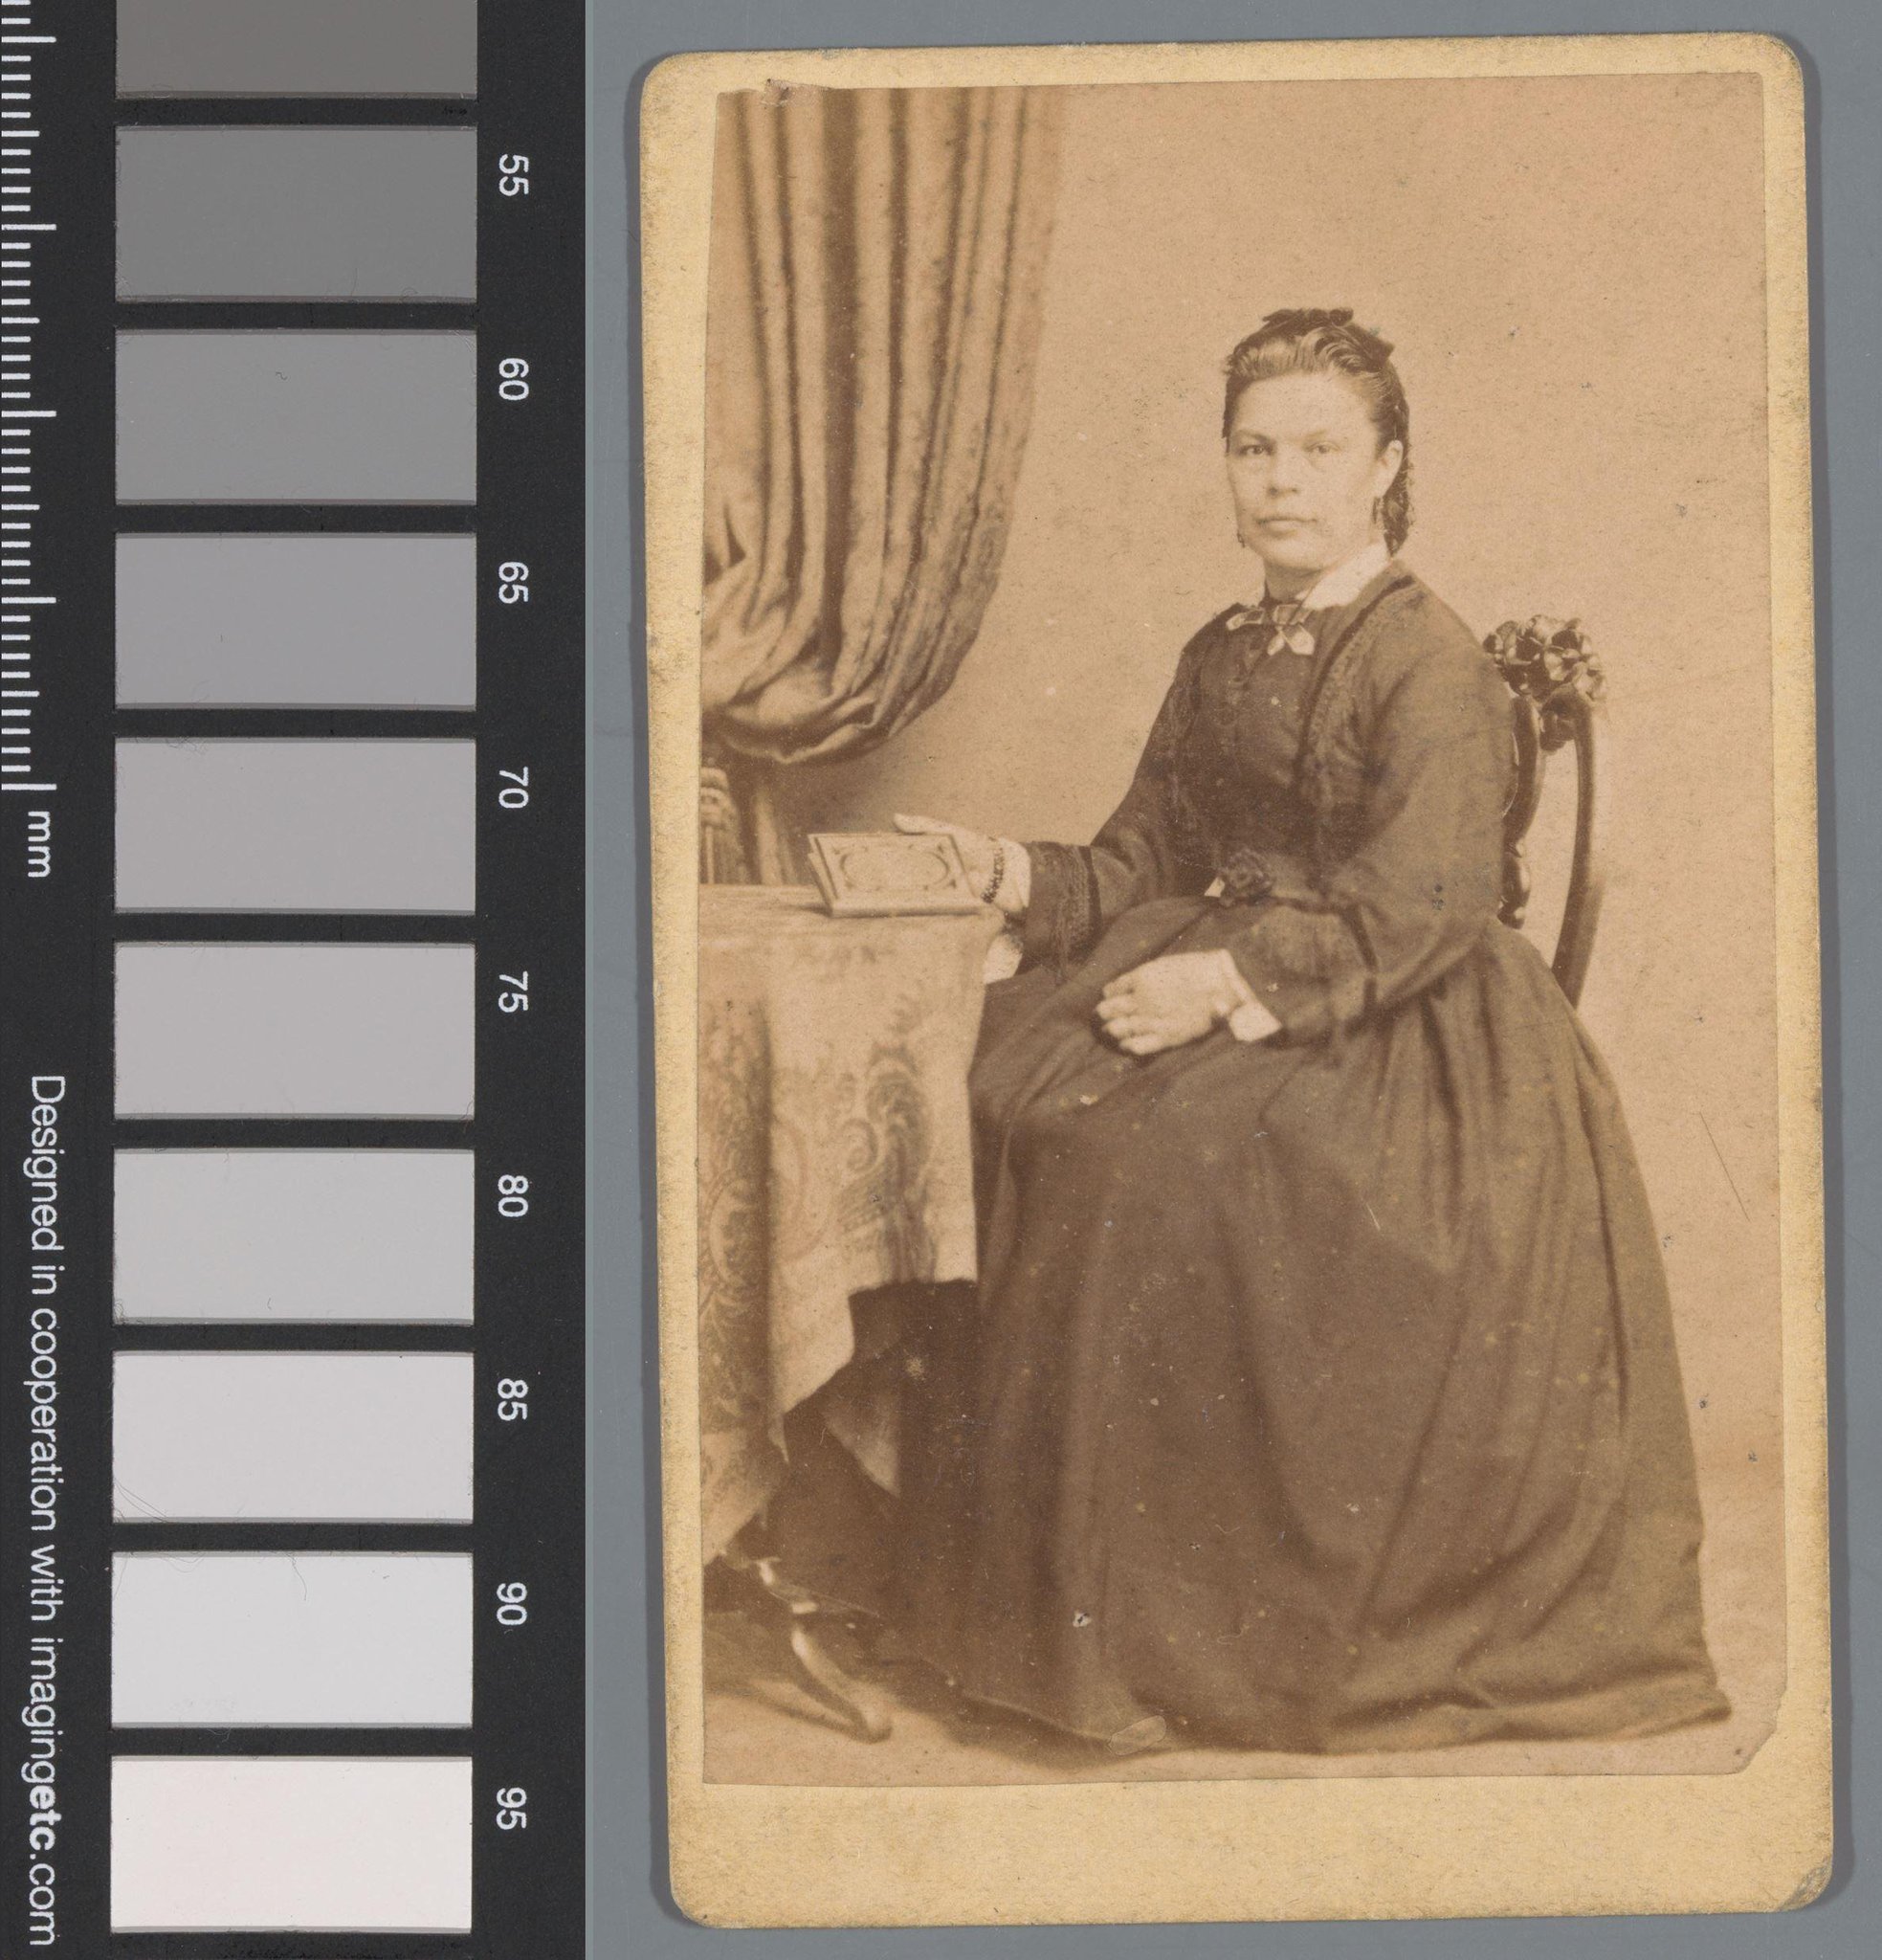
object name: photograph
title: Portret van een onbekende vrouw met een boek aan tafel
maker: c. j. korsten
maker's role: painter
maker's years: 1829-1914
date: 1858-1875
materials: cardboard, paper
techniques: albumen print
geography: zierikzee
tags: adult woman, anonymous historical person portrayed